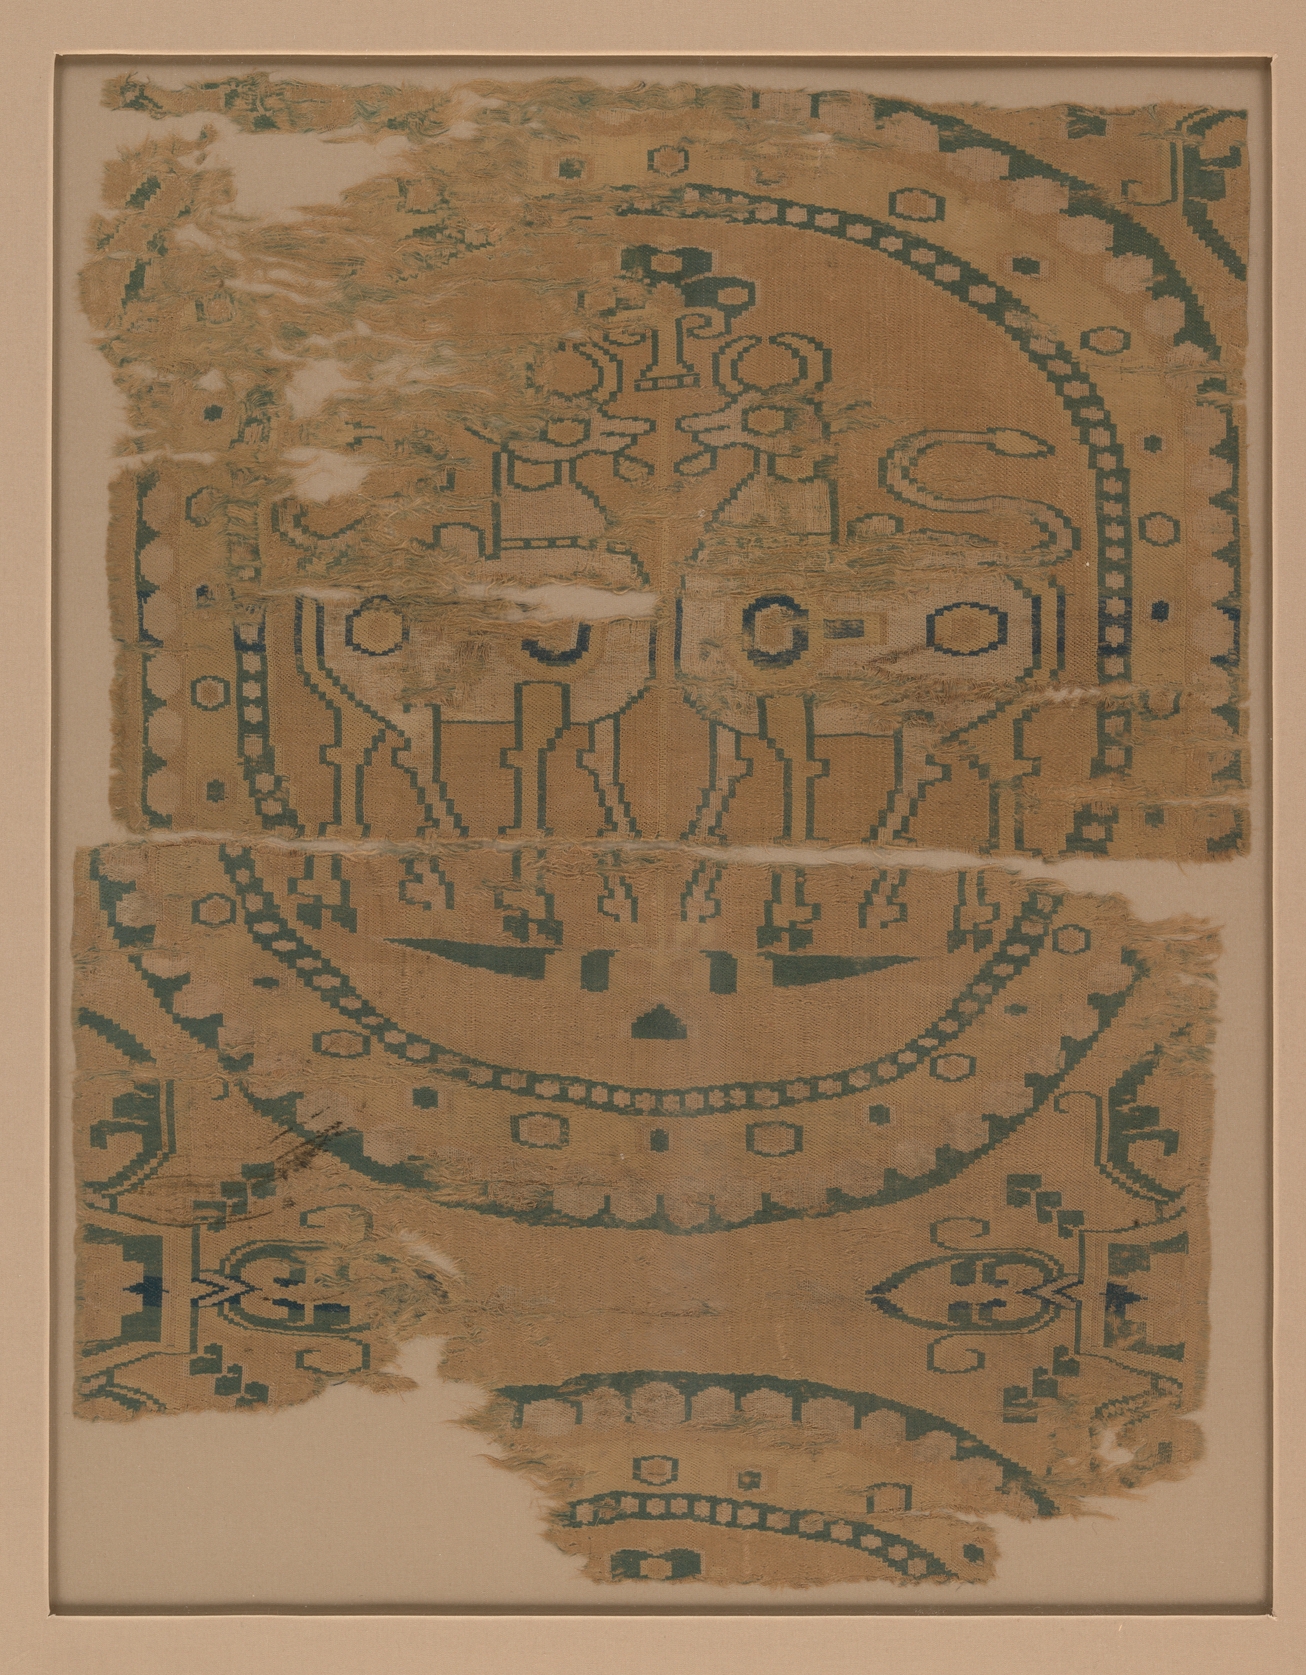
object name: textile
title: Textile with Horned Animals in a Pearl Roundel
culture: chinese or central asian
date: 601-900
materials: silk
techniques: weave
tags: animals